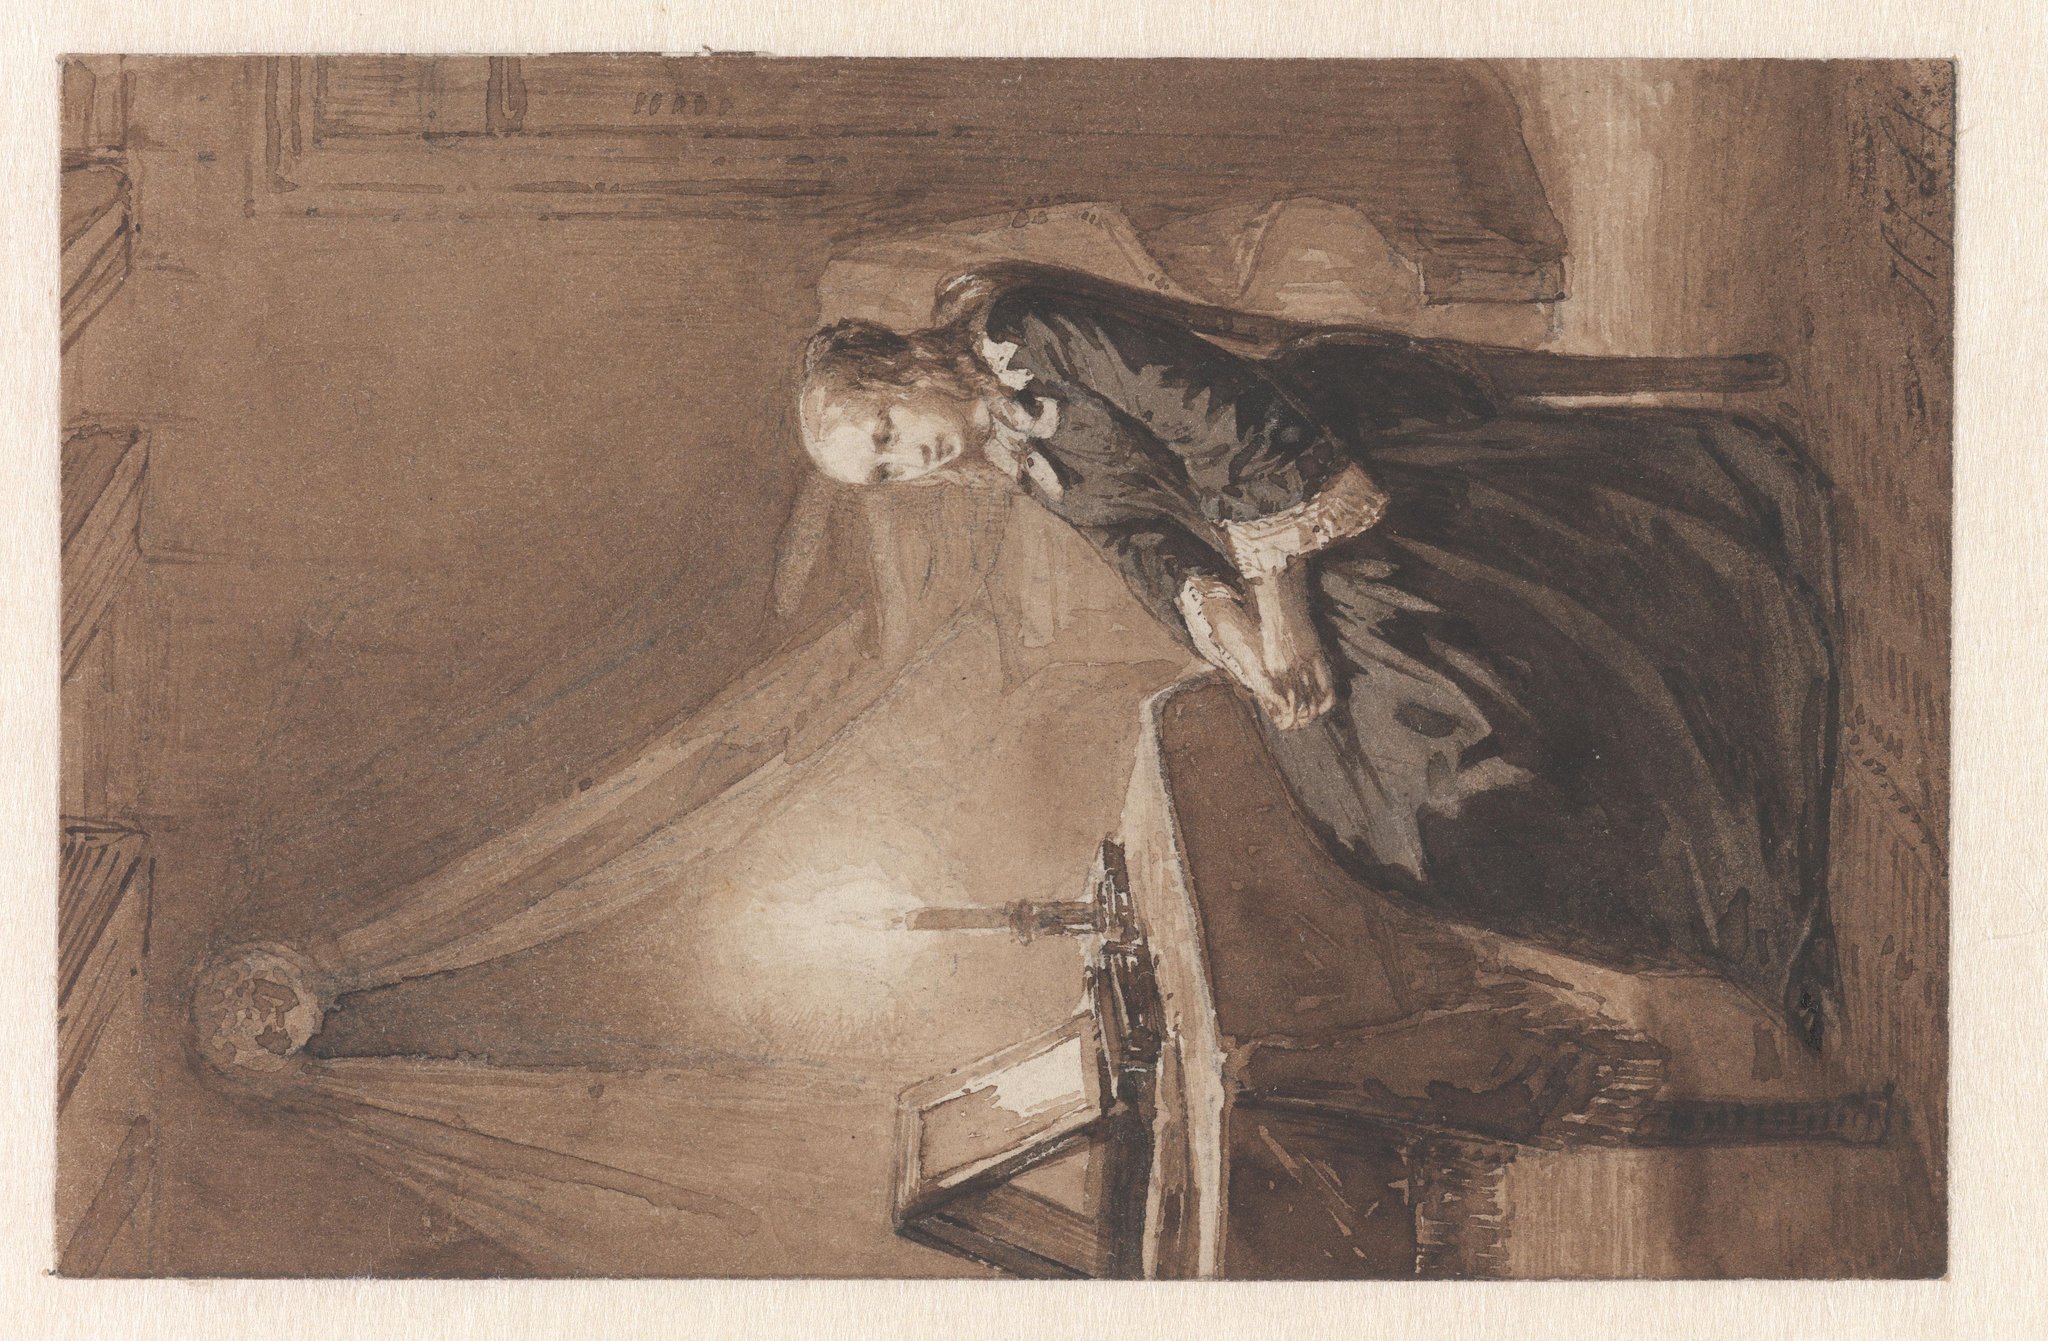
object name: drawing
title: Peinzende dame bij kaarslicht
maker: hendrik jacobus scholten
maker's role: draughtsman, painter, print maker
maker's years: 1824-1907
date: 1834-1907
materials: ink, paper, pencil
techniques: brush, pen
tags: candle (+ kindling a light; lit, burning light, lamp, candle), bedroom